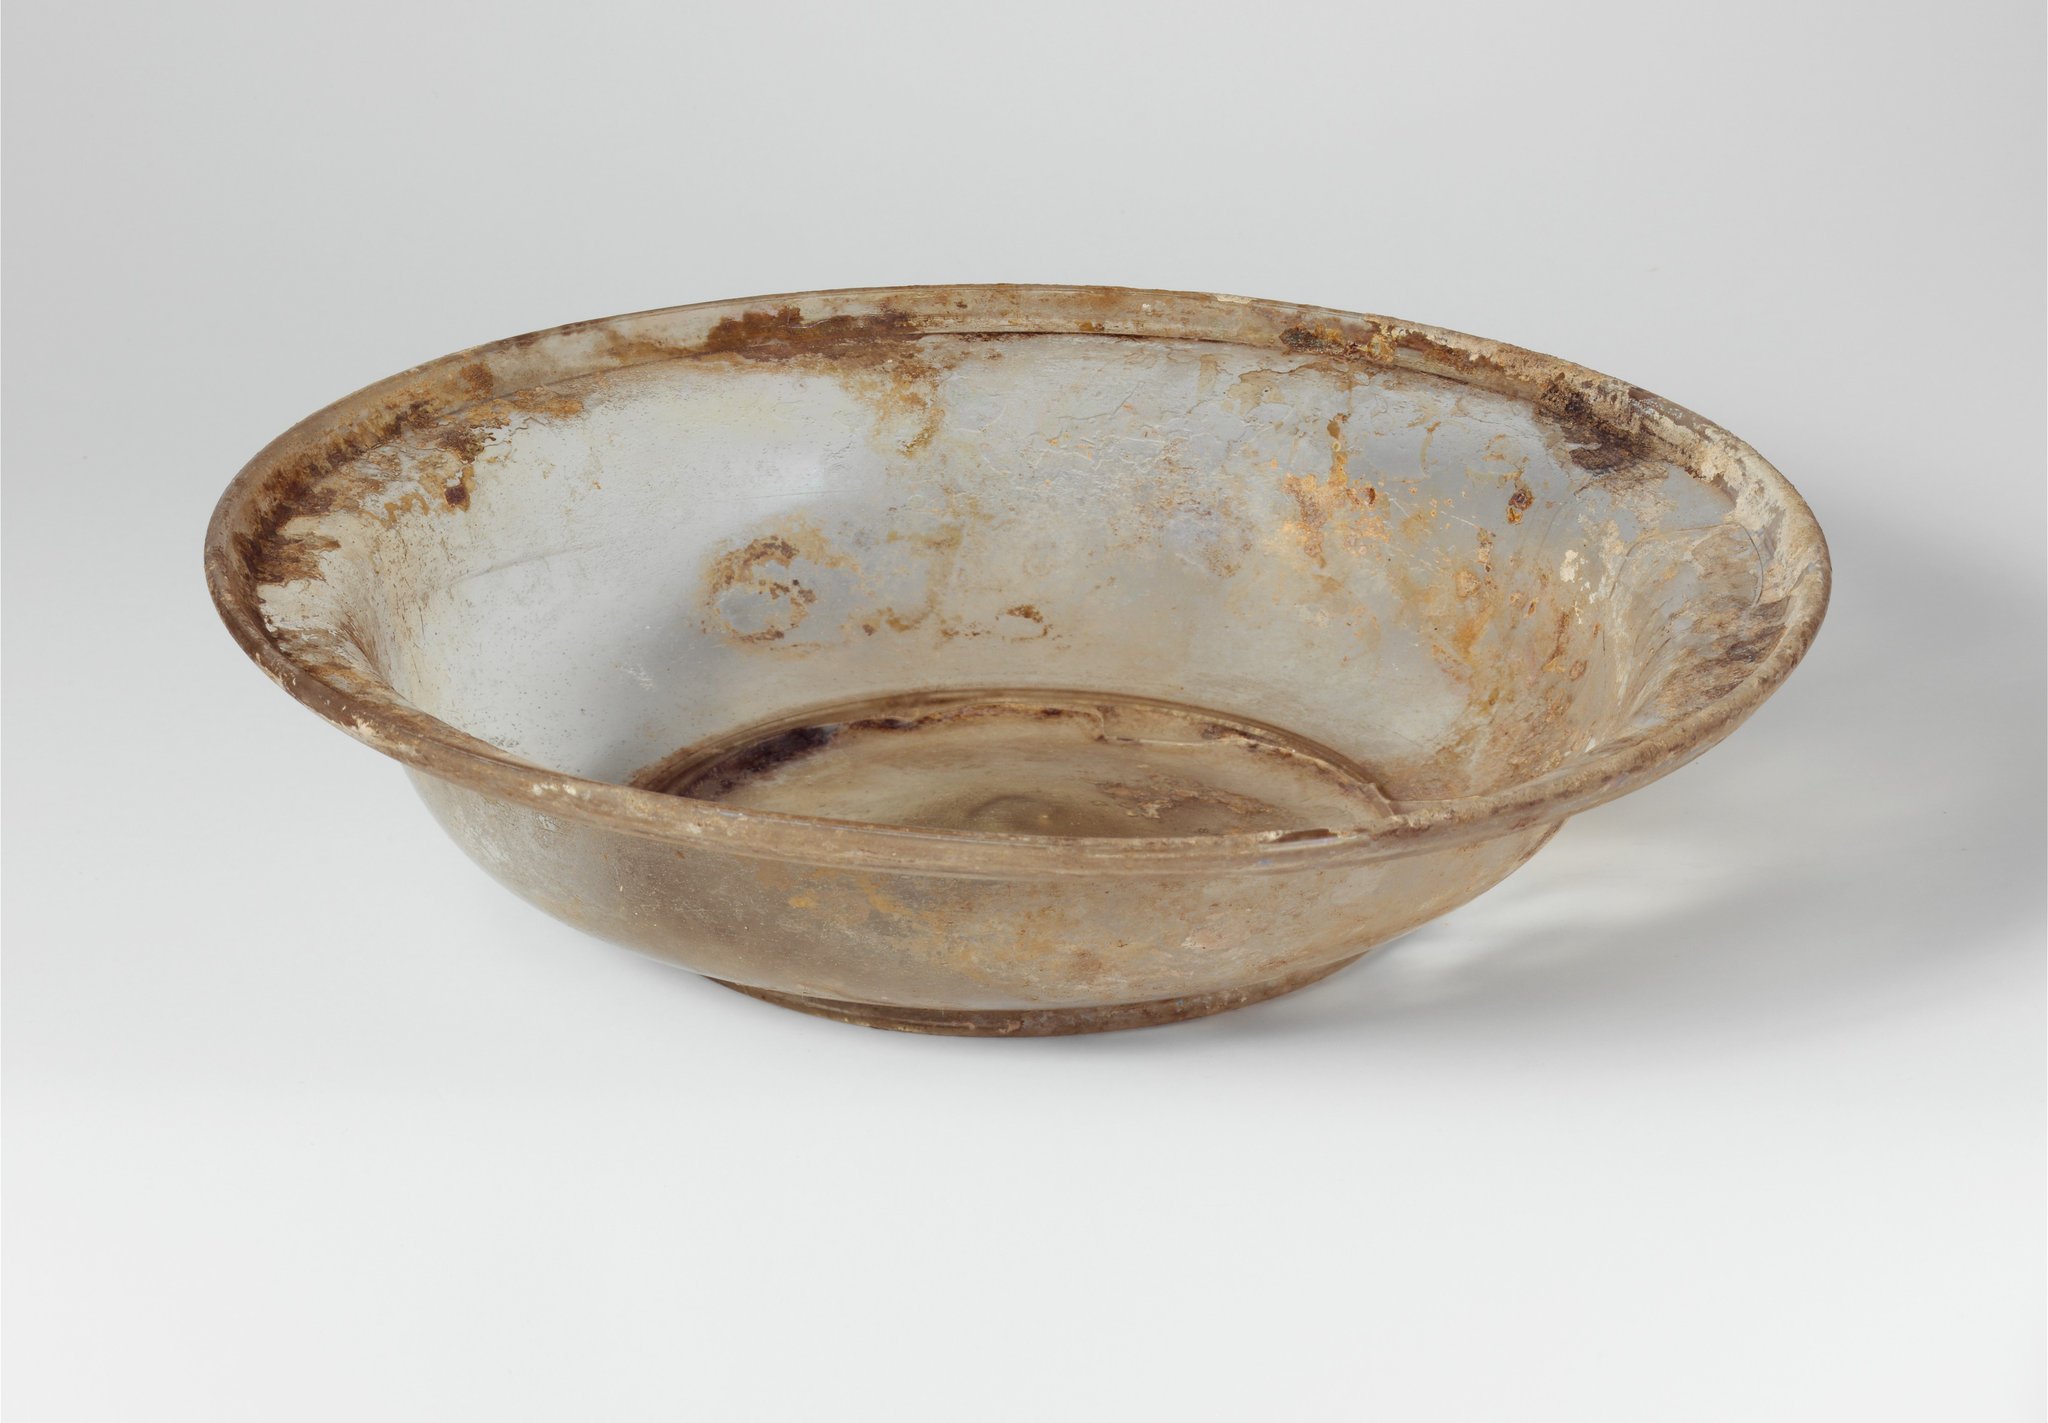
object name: dish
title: Glass dish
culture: roman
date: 301-400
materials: glass